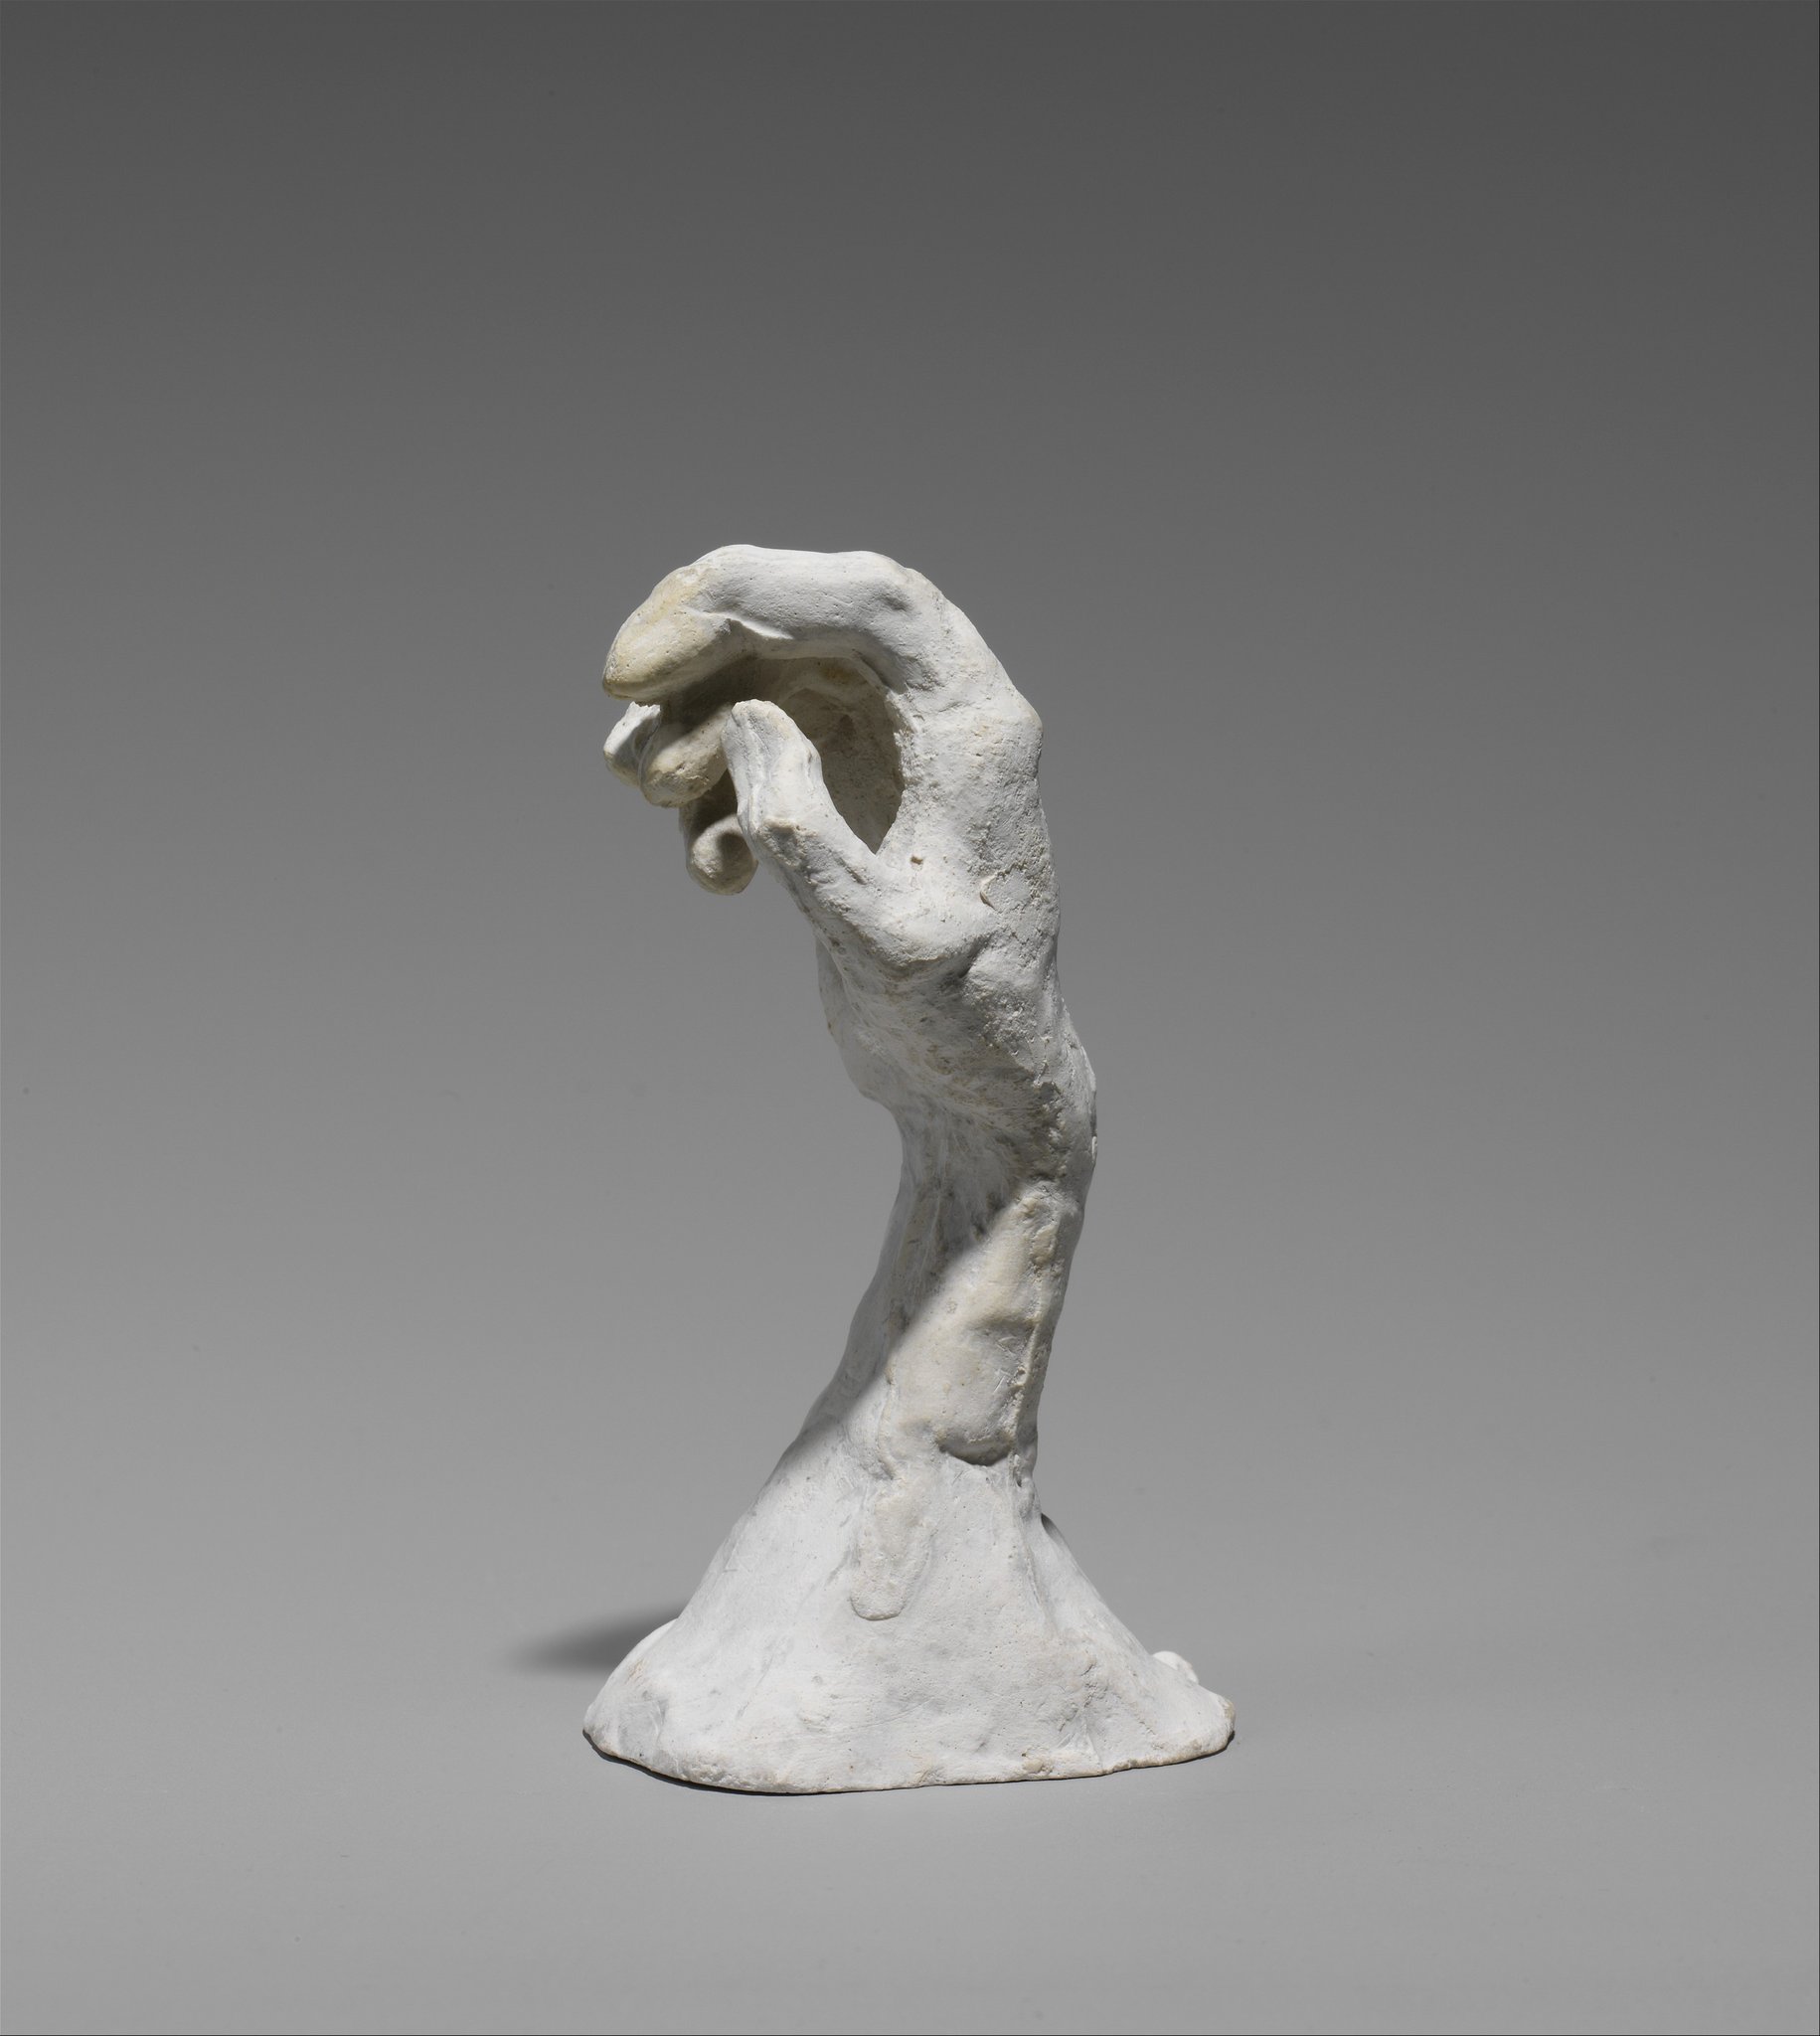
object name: cast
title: Hand with base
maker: auguste rodin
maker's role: artist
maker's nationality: french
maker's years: 1840-1917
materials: plaster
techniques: casting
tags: hands